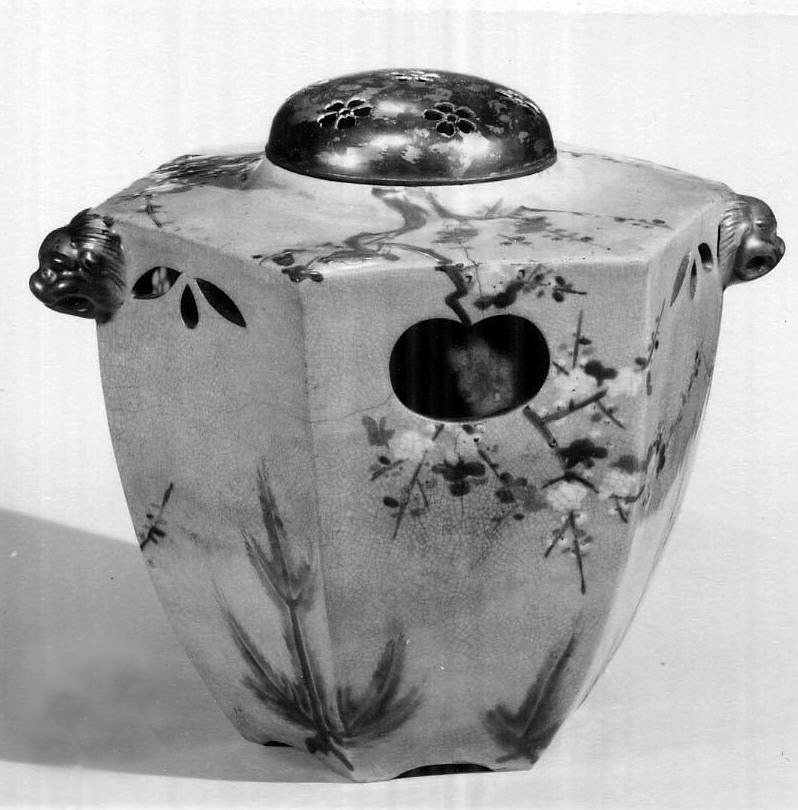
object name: incense burner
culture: japanese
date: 1701-1900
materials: gold, metal, pottery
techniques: overglaze, painting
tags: flowers